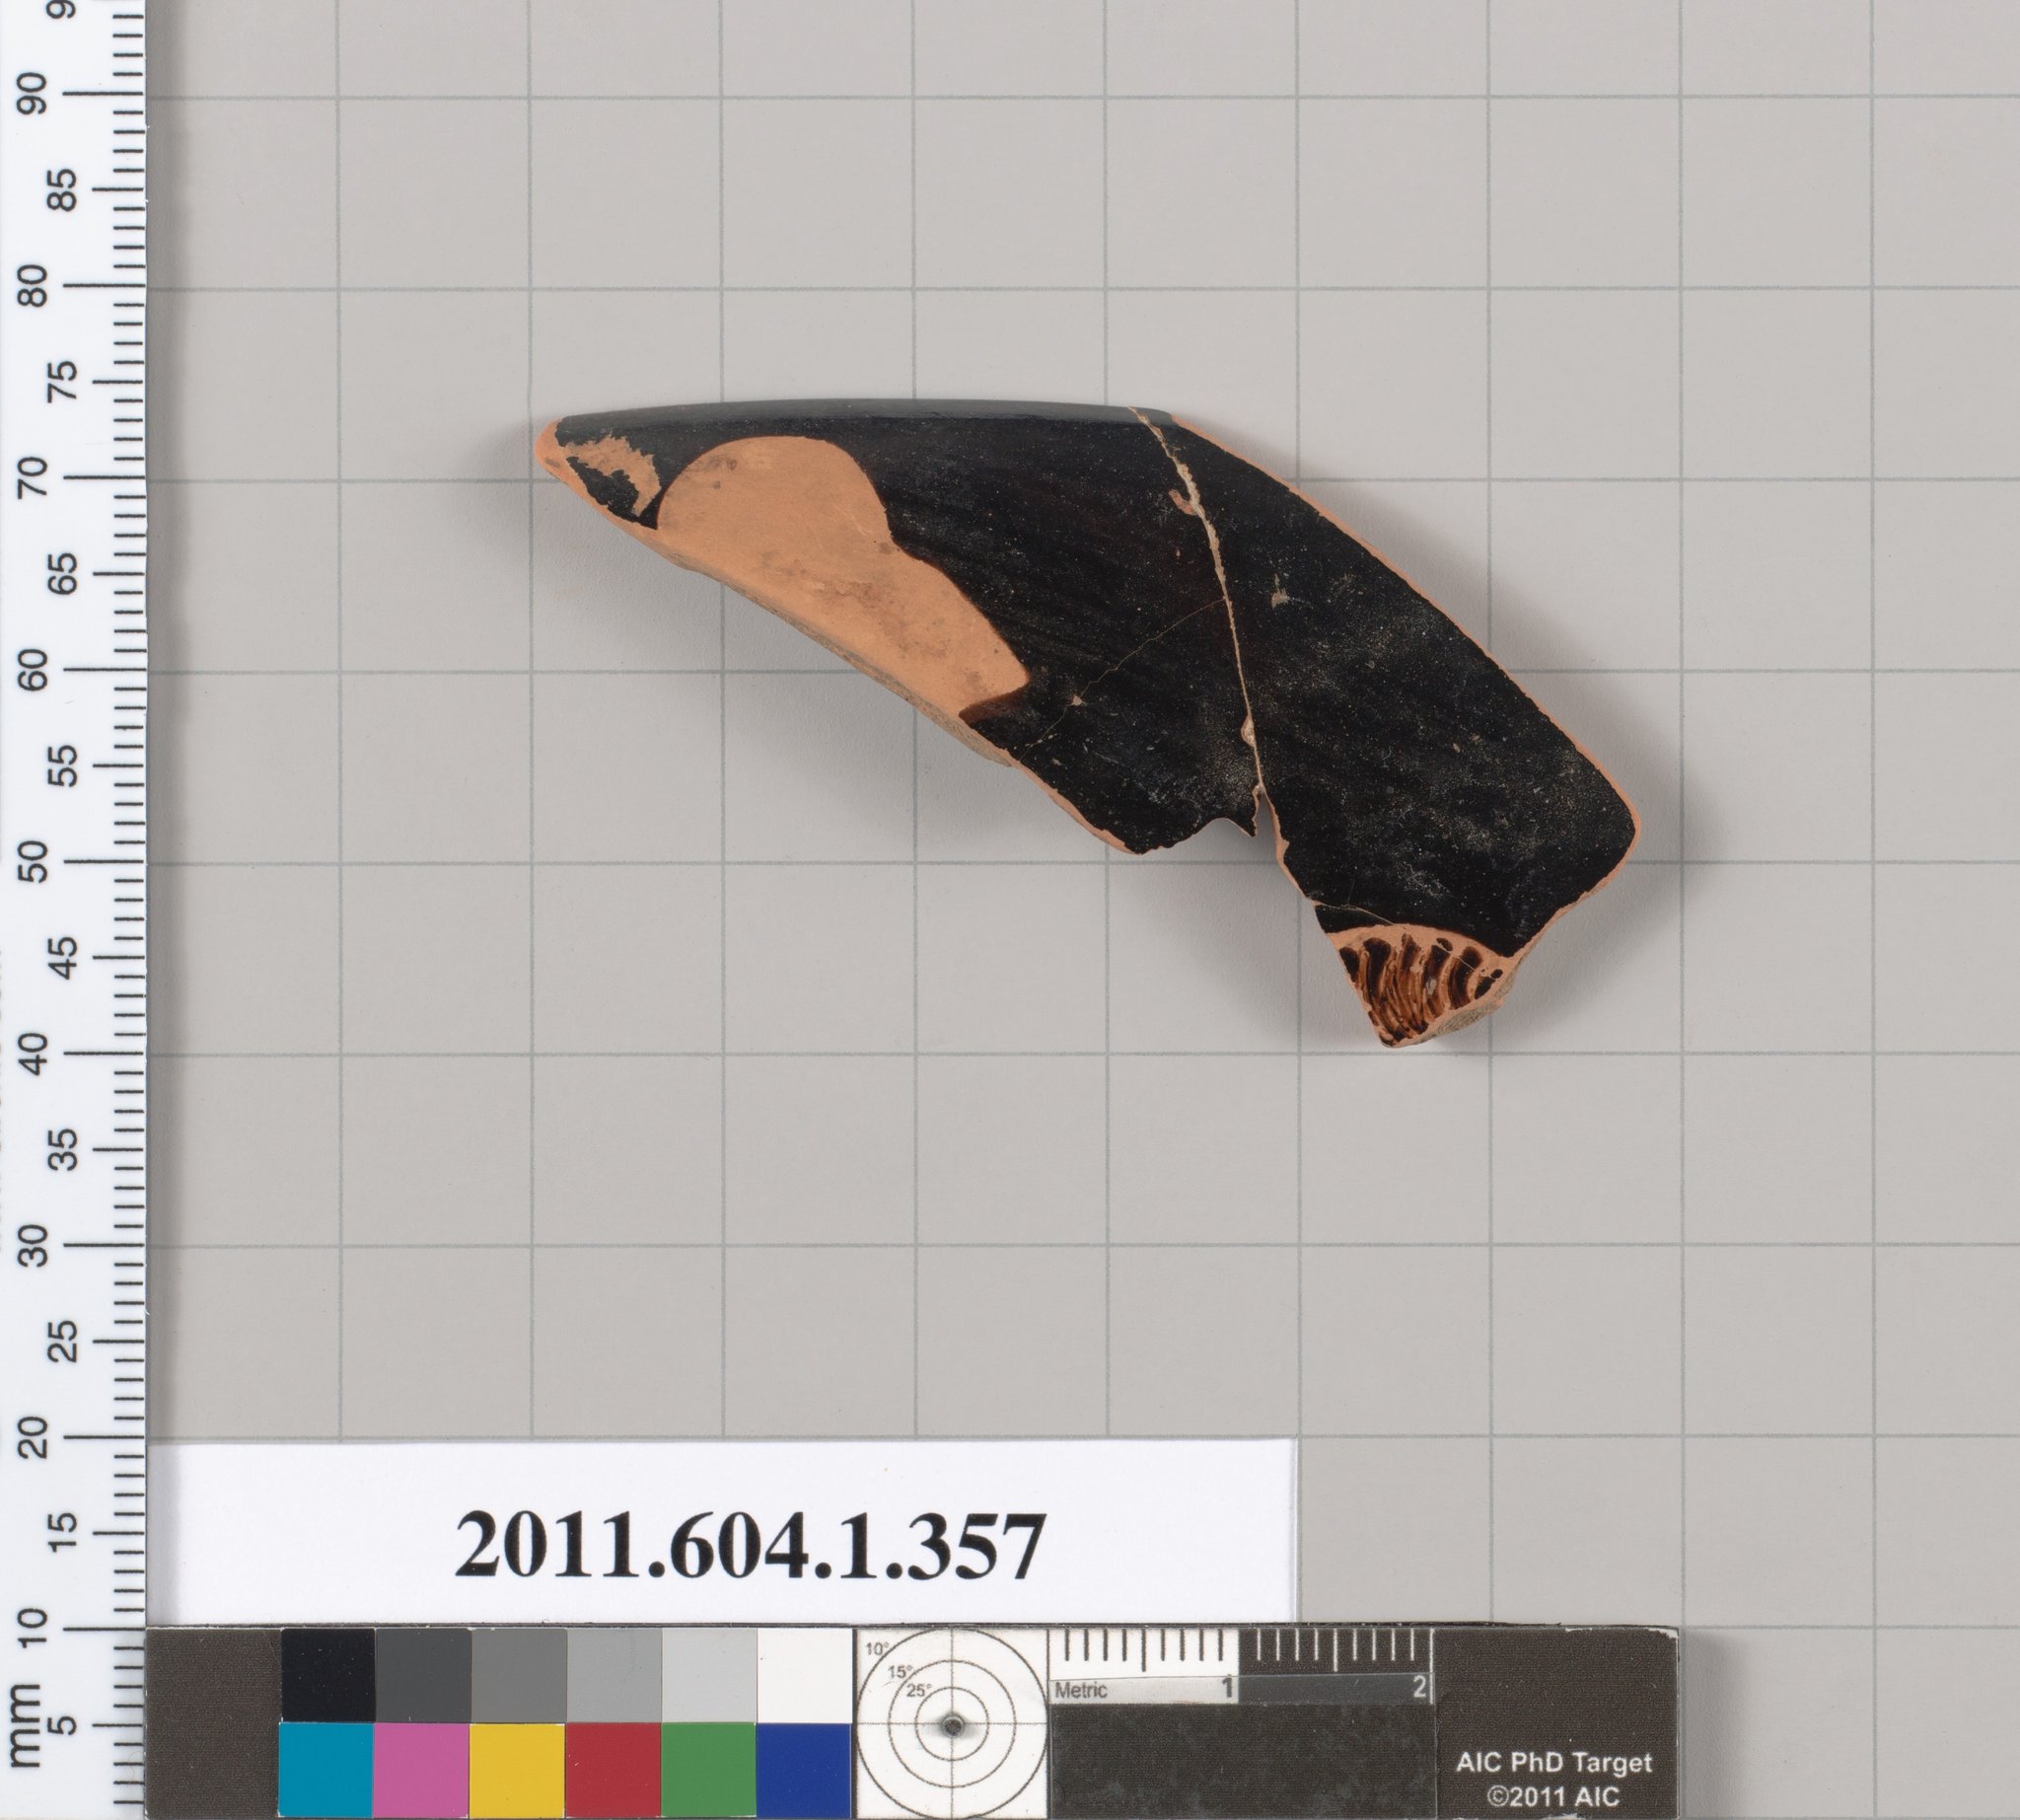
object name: kylix fragment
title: Terracotta rim fragment of a kylix (drinking cup)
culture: greek, attic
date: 475-451 BCE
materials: terracotta